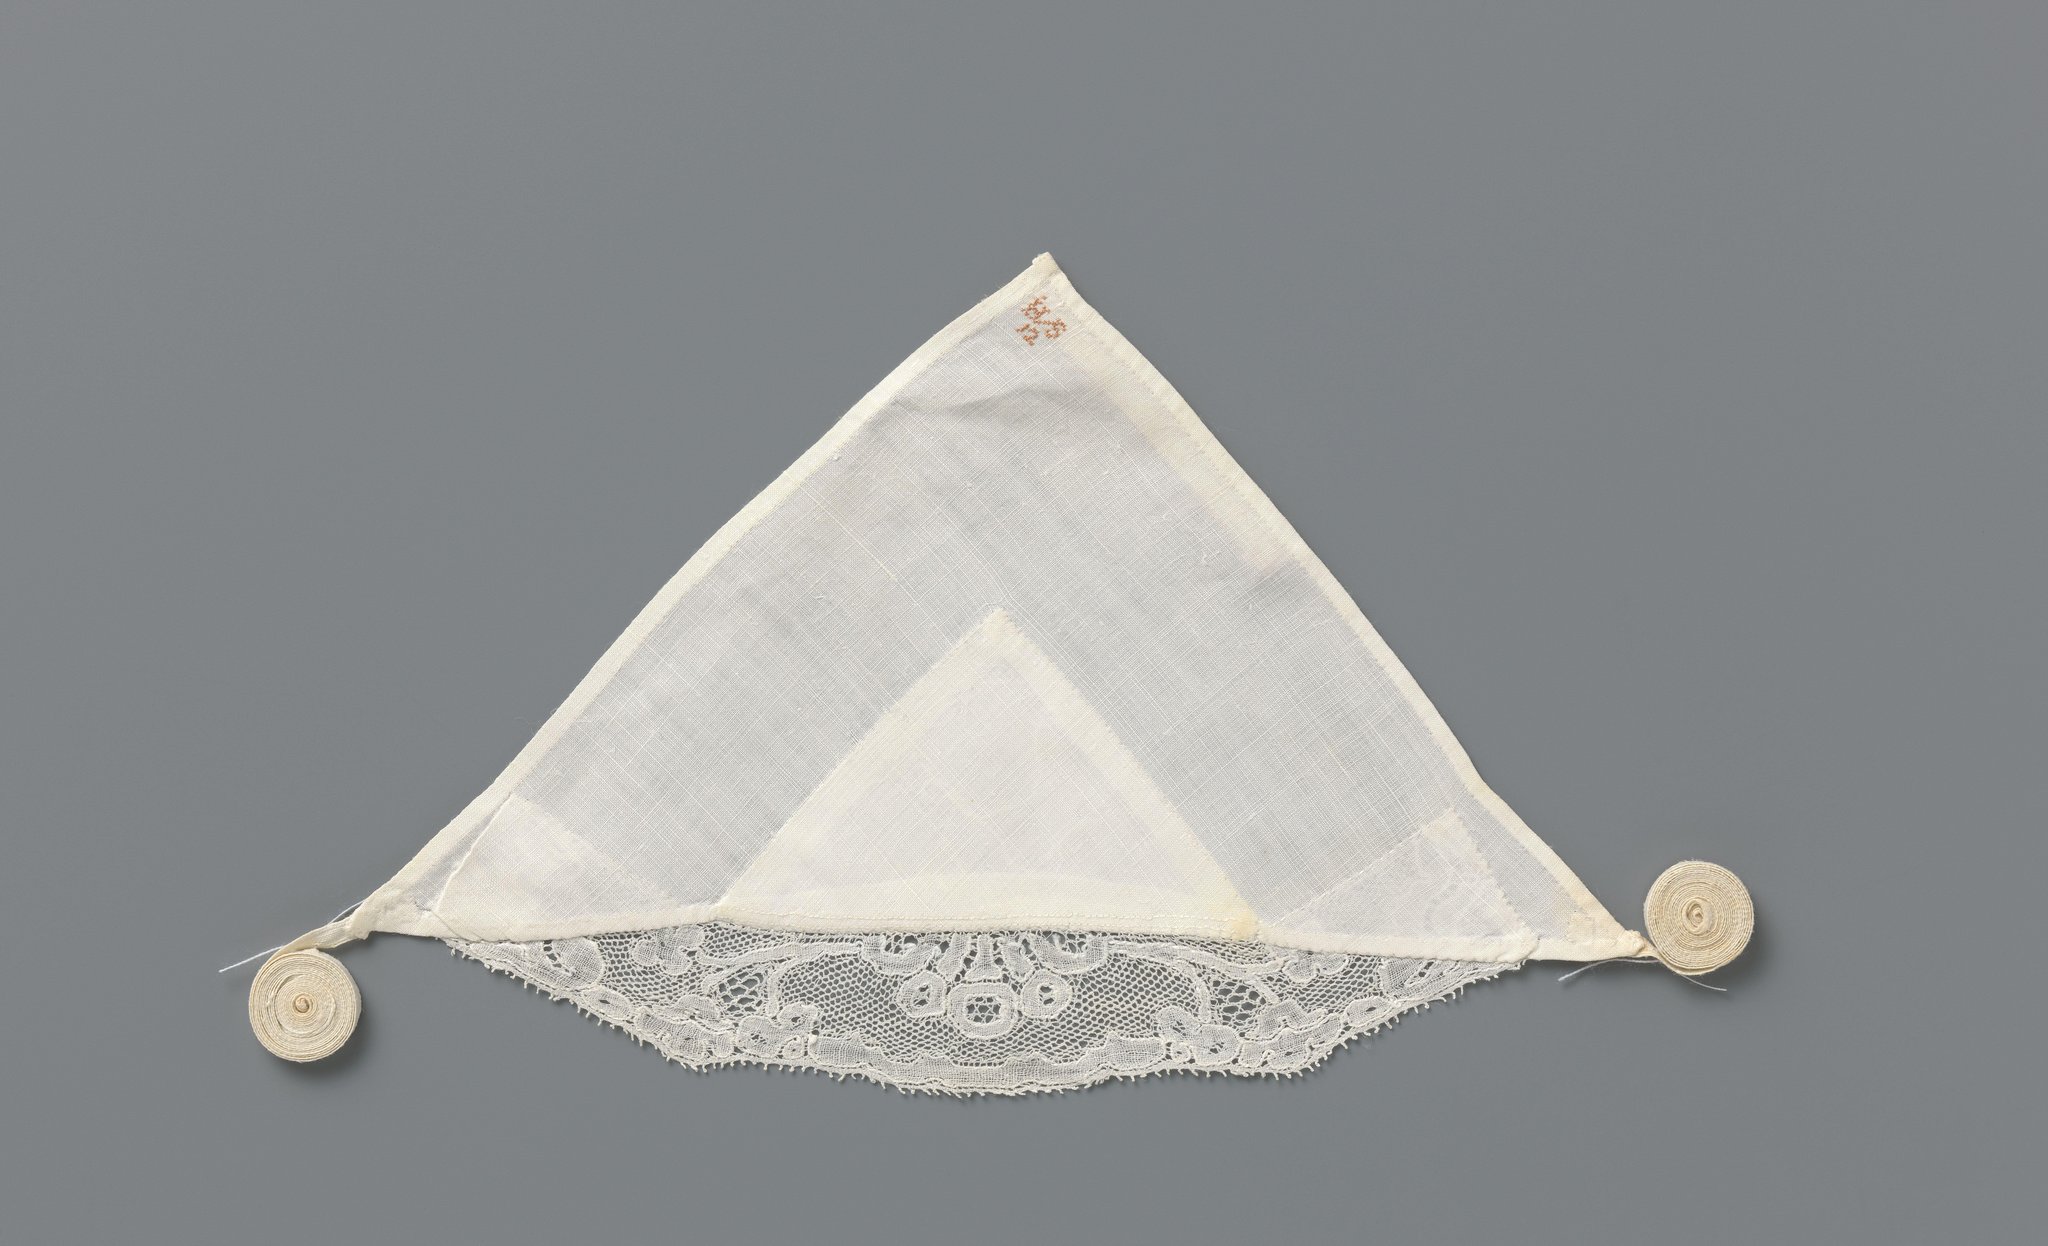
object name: fontaneldoek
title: Fontaneldoek van wit linnen met kant; in rode kruissteek gemerkt: HS12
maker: Anonymous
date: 1750-1900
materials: linen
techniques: cross stitching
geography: europe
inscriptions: inscription: ‘HS / 12’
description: 12 linnen fontanelletjes met verschillende kant afgezet , 4 gemerkt LH8, 3 gem. H8, 5 gem. HVS(Gr. Hoogenhuize "1772-1852" tr. 1802 S.E. von schmid "1771-1843"). 1 van damast gem. HH6 (W.r. Hoogenhuize "1747-1804" tr 1787 W. Helmerich "1752").